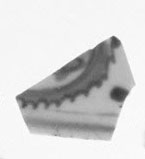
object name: shard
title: Shard (Study Collection)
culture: chinese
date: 1368-1911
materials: porcelain